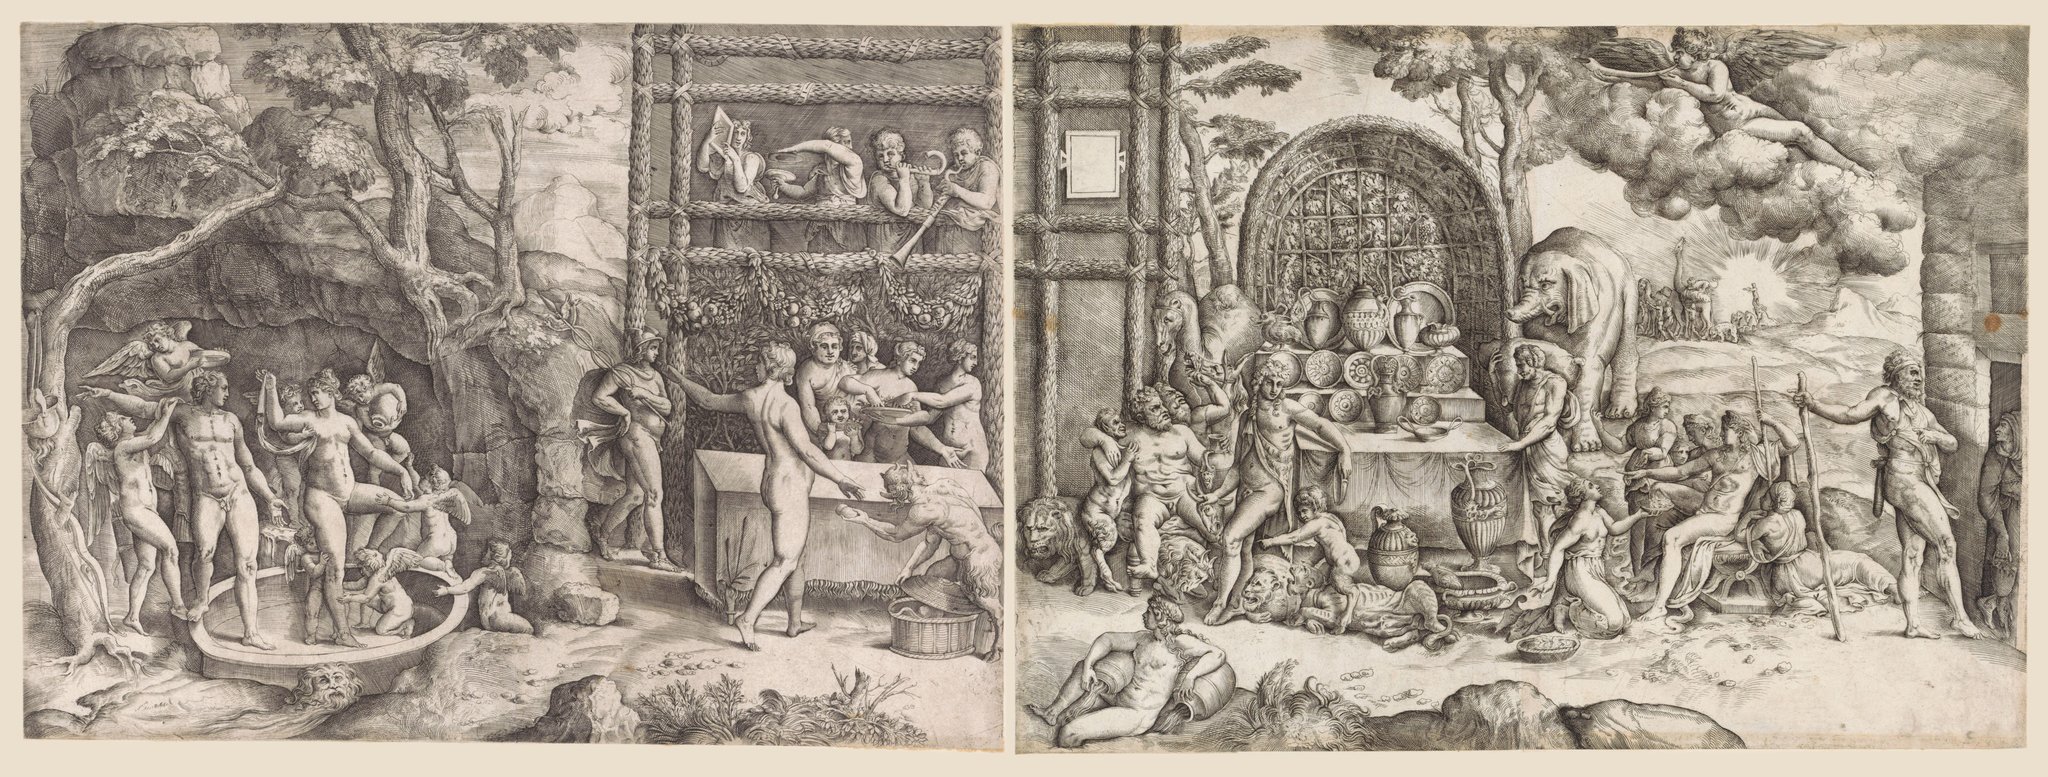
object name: album leaf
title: Huwelijksfeest van Amor en Psyche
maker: battista franco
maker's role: draughtsman, painter, print maker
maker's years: 1510-1561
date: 1520-1561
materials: paper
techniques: engraving, etching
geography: venice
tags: marriage of cupid and psyche, beasts of prey, predatory animals: lion, trunked animals: elephant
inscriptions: watermark, collector's mark: Lugt 2760, watermark, collector's mark: Lugt 2228, inscription: ‘36’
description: Folio's 35 en 36 uit het prentalbum van Johann Georg I. Zobel von Giebelstadt (Röttingen 1543-07-20 - Bamberg 1580-09-07), de latere bisschop van Bamberg. Het album is vermoedelijk samengesteld tussen 1568 en 1570 in Venetië. Het album werd in 1999 uit elkaar genomen door een antiquair. De in totaal 124 folio's met prenten uit het "Zobel Album" werden aangekocht door verschillende musea en privéverzamelingen. De grootste groep (68 folio's) bevindt zich in de collectie van het Rijksmuseum. Giovanni Battista Franco kopieerde deze voorstelling naar een fresco door Giulio Romano op de zuid-west wand van de Camera di Amore e Psyche, in het Palazzo del Te in Mantua. Dit object is omwille van een betere presentatie virtueel samengevoegd, maar bestaat fysiek uit losse onderdelen.